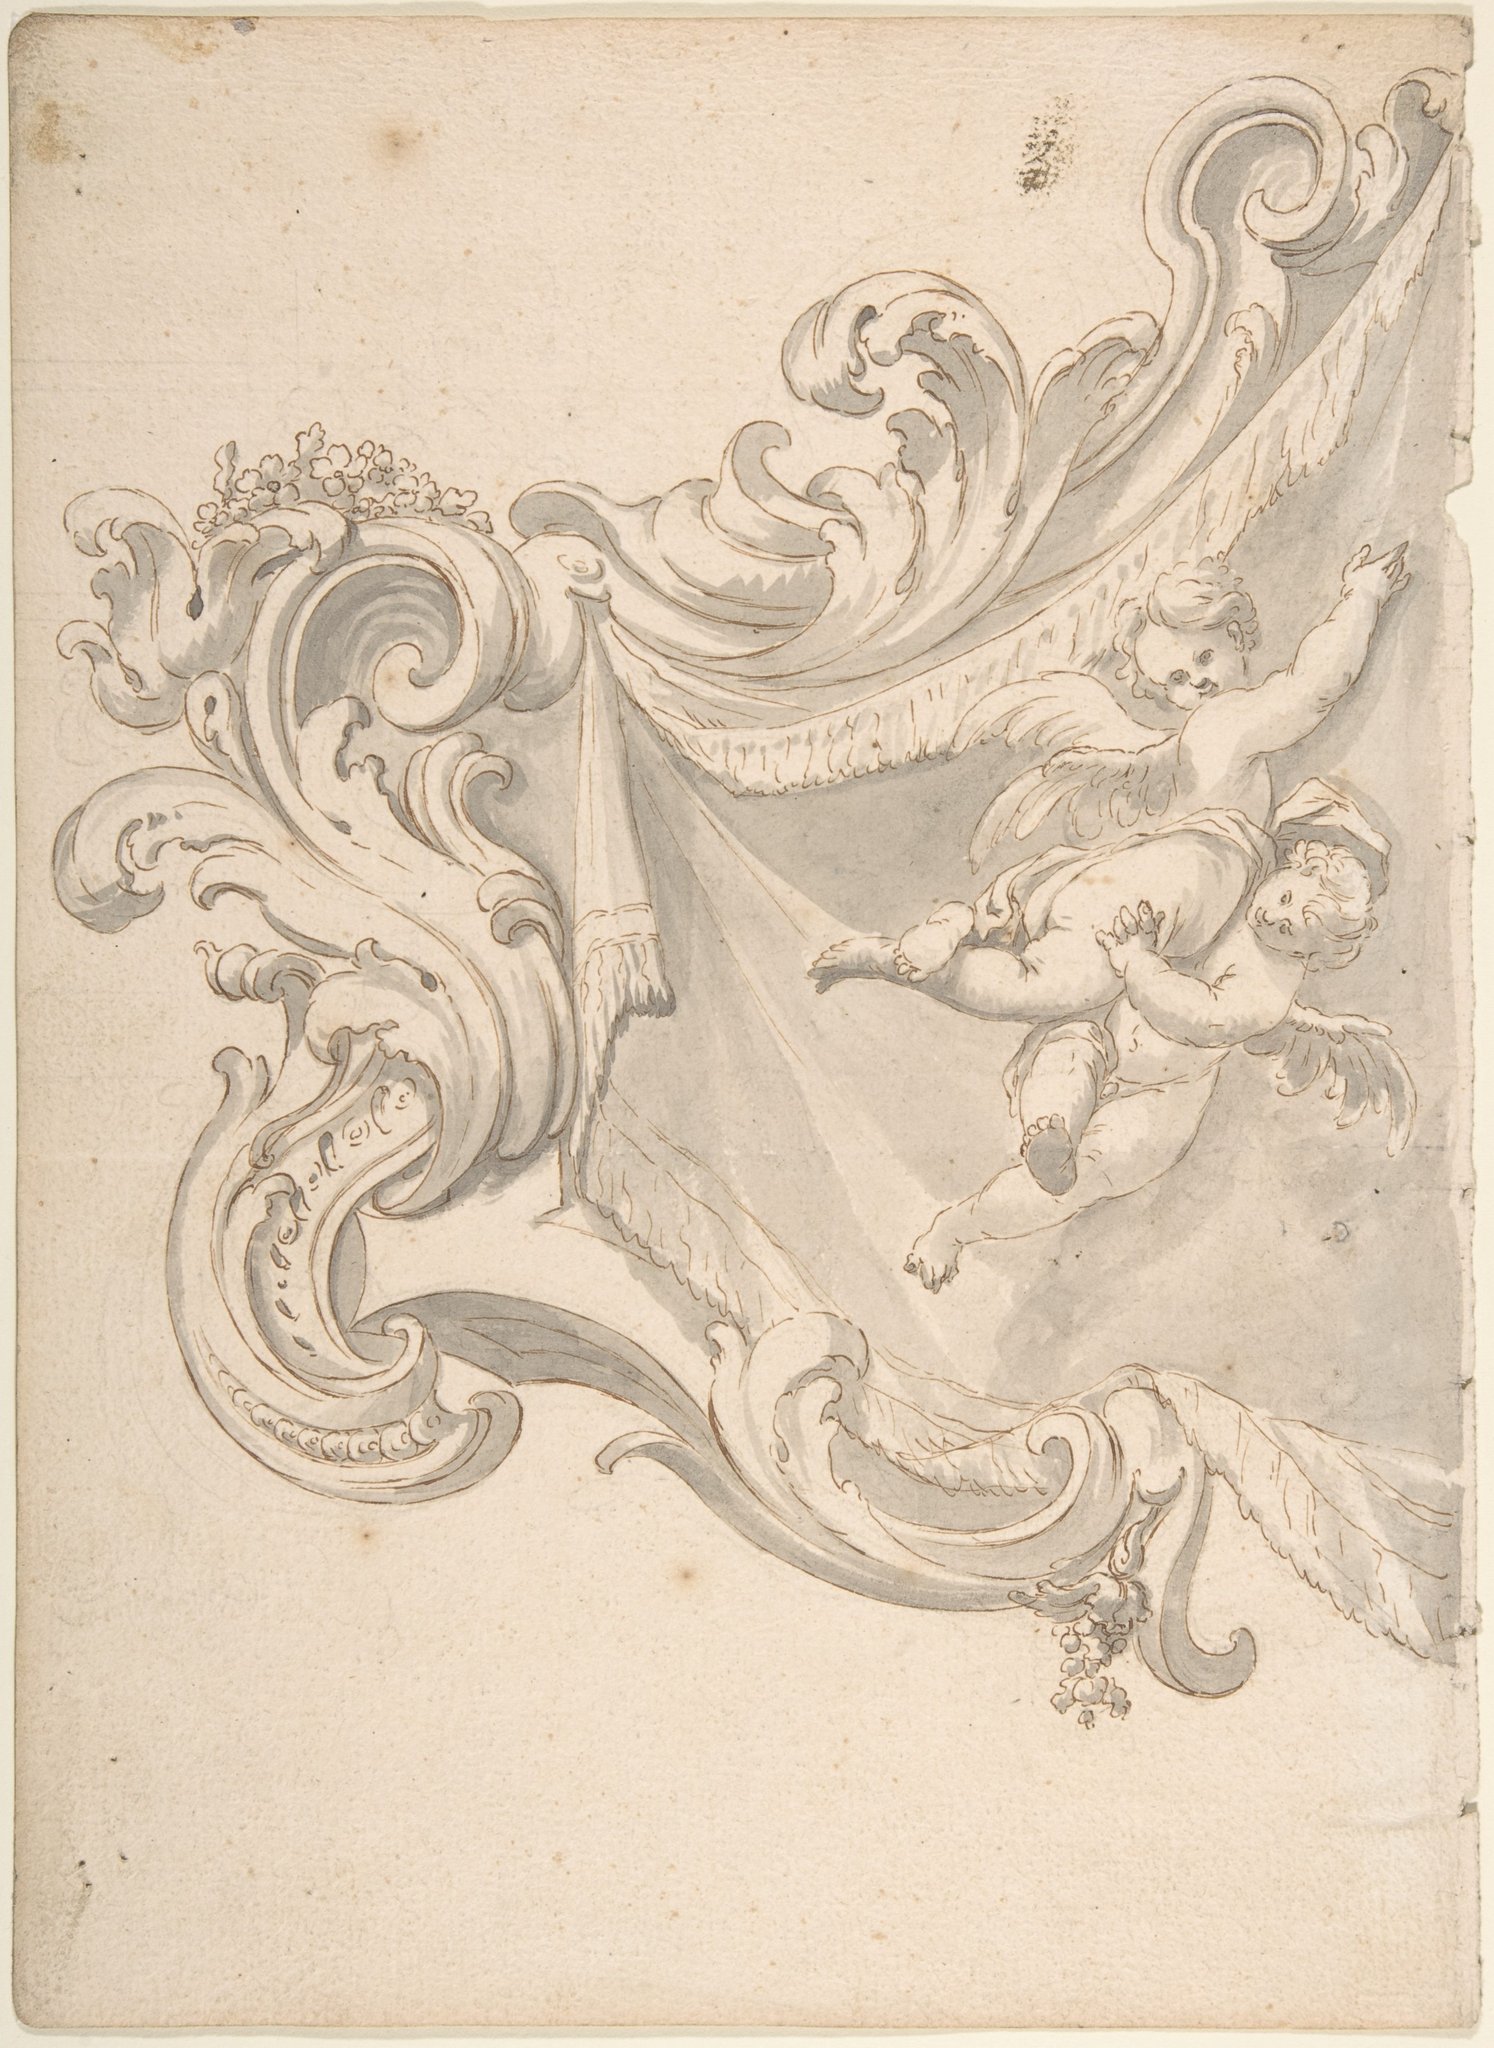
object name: drawing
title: Design for a Crest with Drapery and Two Putti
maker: anonymous, italian, piedmontese, 18th century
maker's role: artist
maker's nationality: italian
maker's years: 1700-1800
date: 1700-1780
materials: graphite, ink, drawing material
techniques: brush, pen, wash